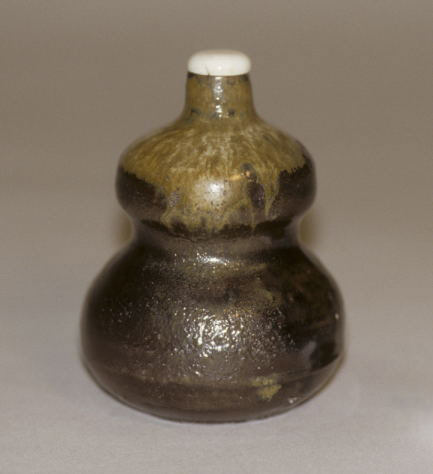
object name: tea caddy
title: Gourd-shaped Tea Caddy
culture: japanese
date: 1701-1800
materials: clay, glaze